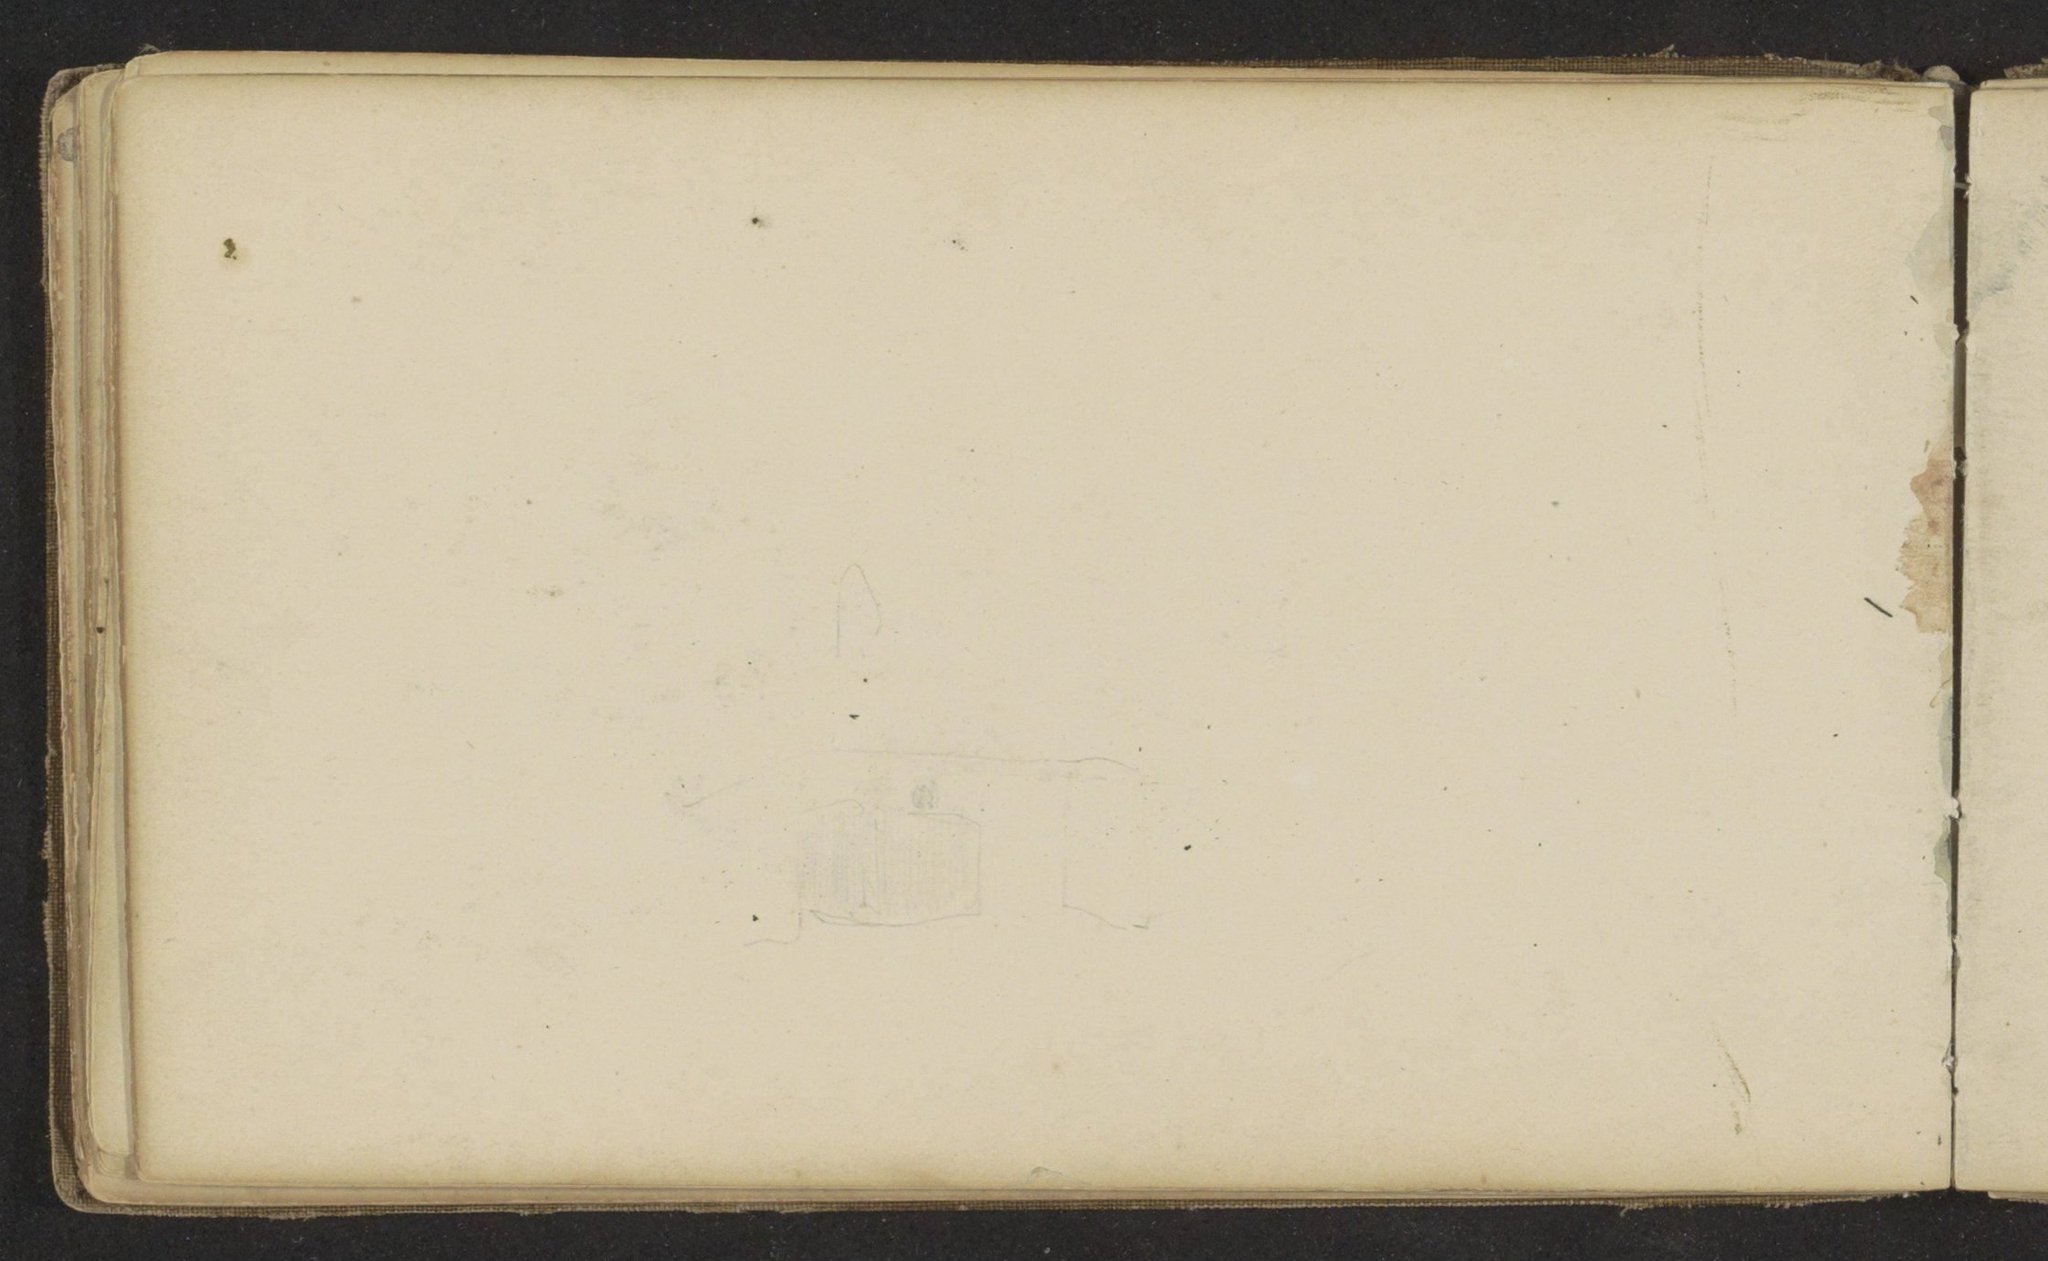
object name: sketchbook leaf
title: Studie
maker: johan hendrik weissenbruch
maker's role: draughtsman, painter, print maker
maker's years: 1824-1903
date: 1834-1903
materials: paper, pencil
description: Blad 24 verso uit een schetsboek met 43 bladen.